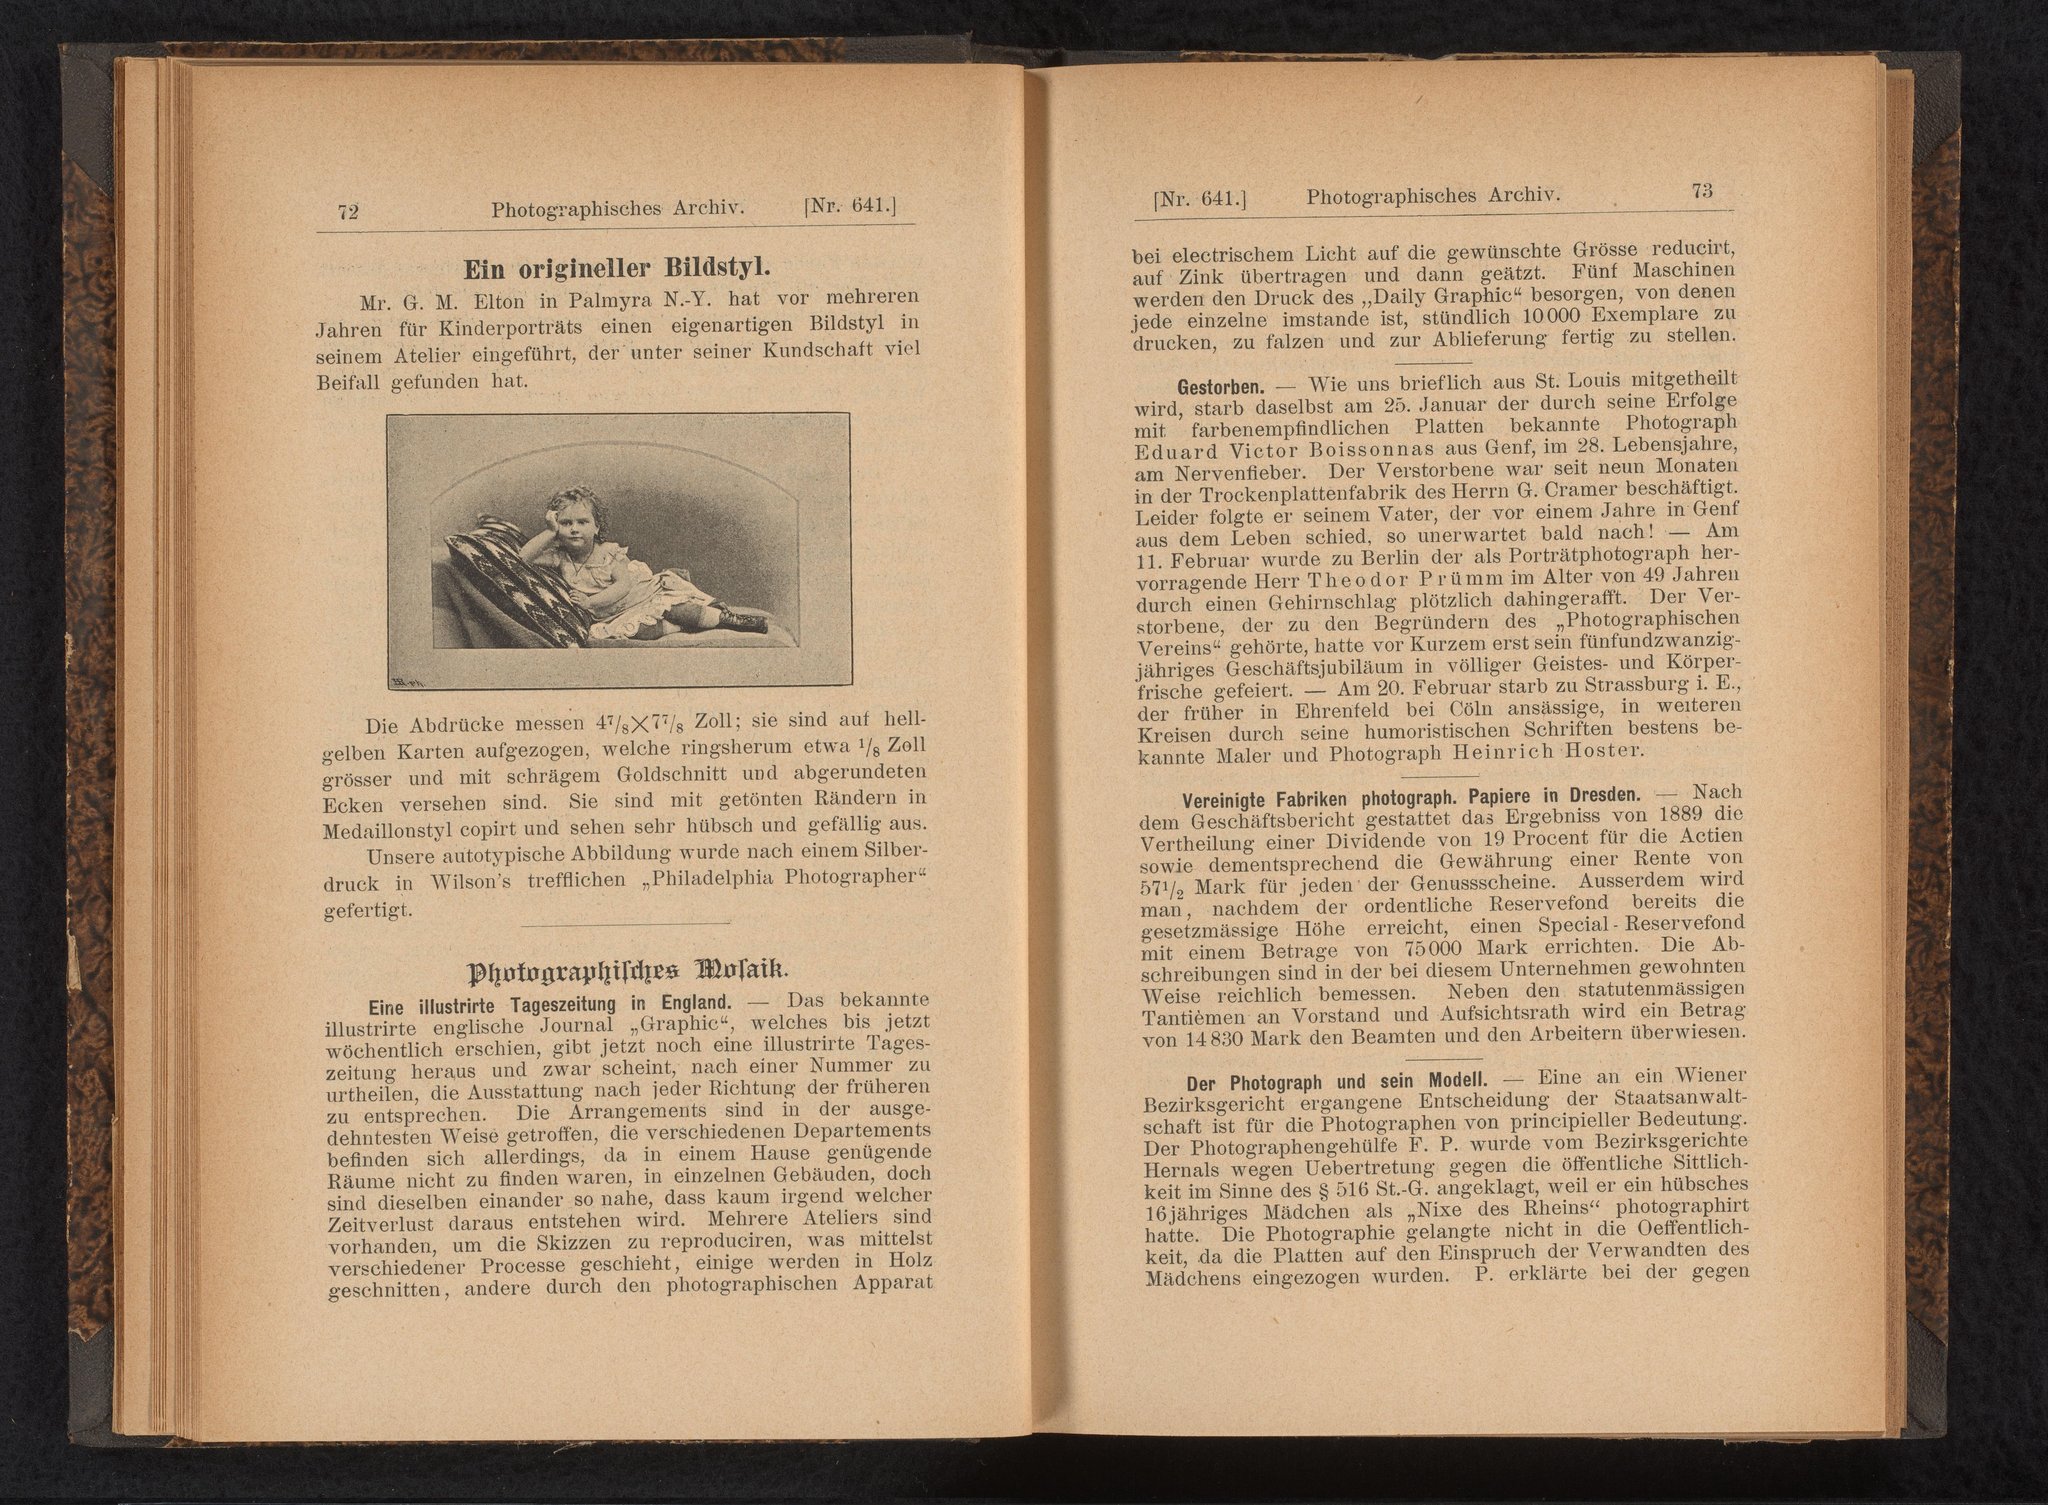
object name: photomechanical print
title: Portret van een onbekend kind, liggend met een arm onder het hoofd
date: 1885-1890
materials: paper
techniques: autotype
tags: child, lying on one side, with uplifted upper part of the body and leaning on the arm, historical persons not known by name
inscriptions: signature: ‘HR ph.’